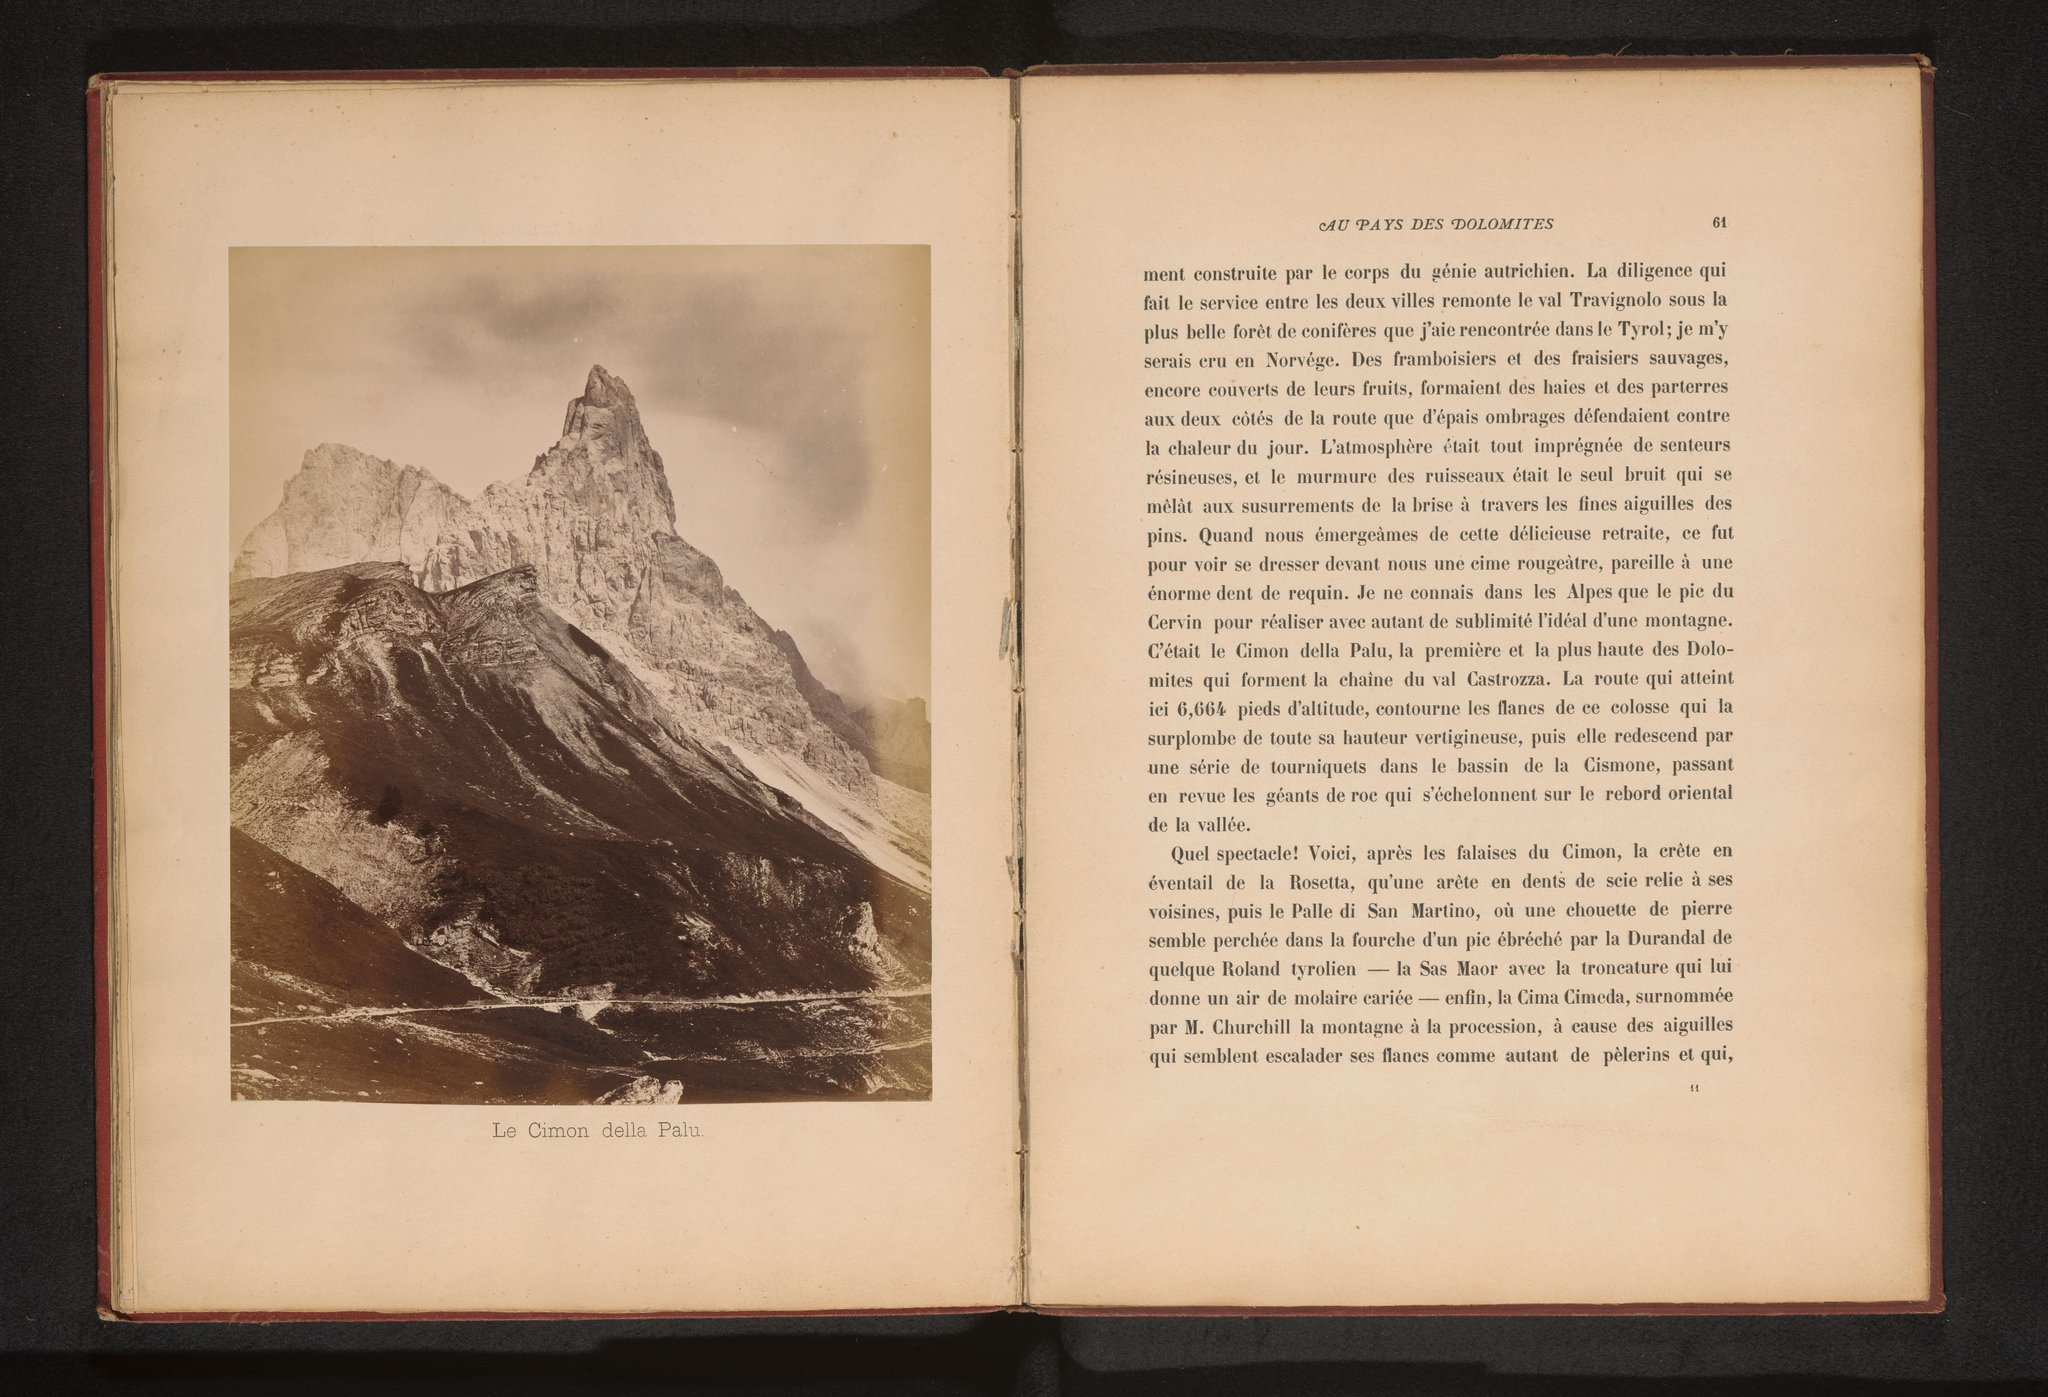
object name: photograph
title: Gezicht op de berg Cimon della Pala in de Dolomieten, Italië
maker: eugène goblet dalviella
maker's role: politician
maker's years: 1846-1925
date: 1873-1878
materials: photographic support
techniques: albumen print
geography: dolomites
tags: mountain-range, snow peaks, mountains